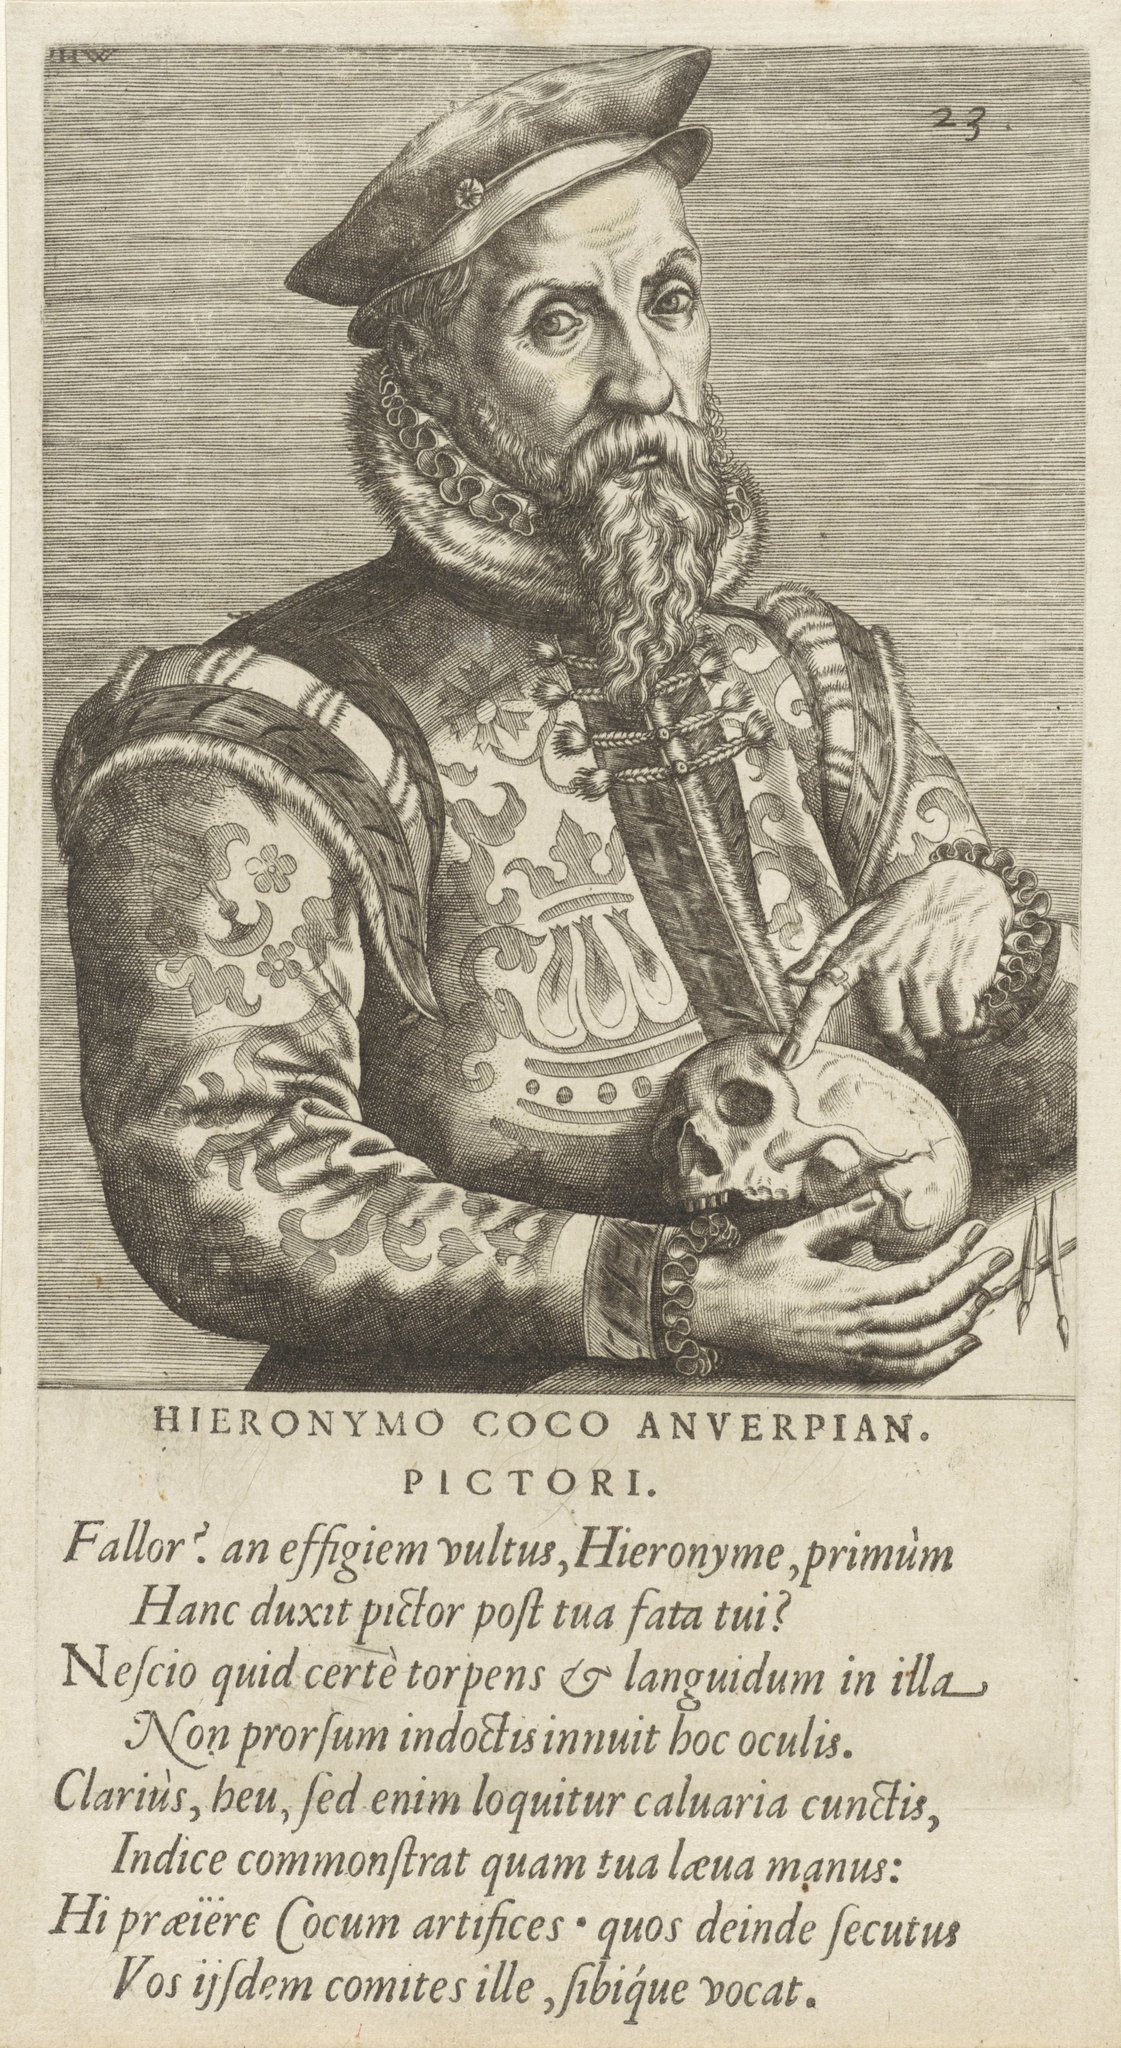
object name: print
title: Portret van de schilder Hieronymus Cock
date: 1572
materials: paper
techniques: engraving, letterpress printing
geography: antwerp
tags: antwerp, print maker, publisher, hieronymus cock, portrait, self-portrait of painter, death's head, skull (symbol of death)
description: Hij wijst op een schedel. In de marge een achtregelig onderschrift in het Latijn.